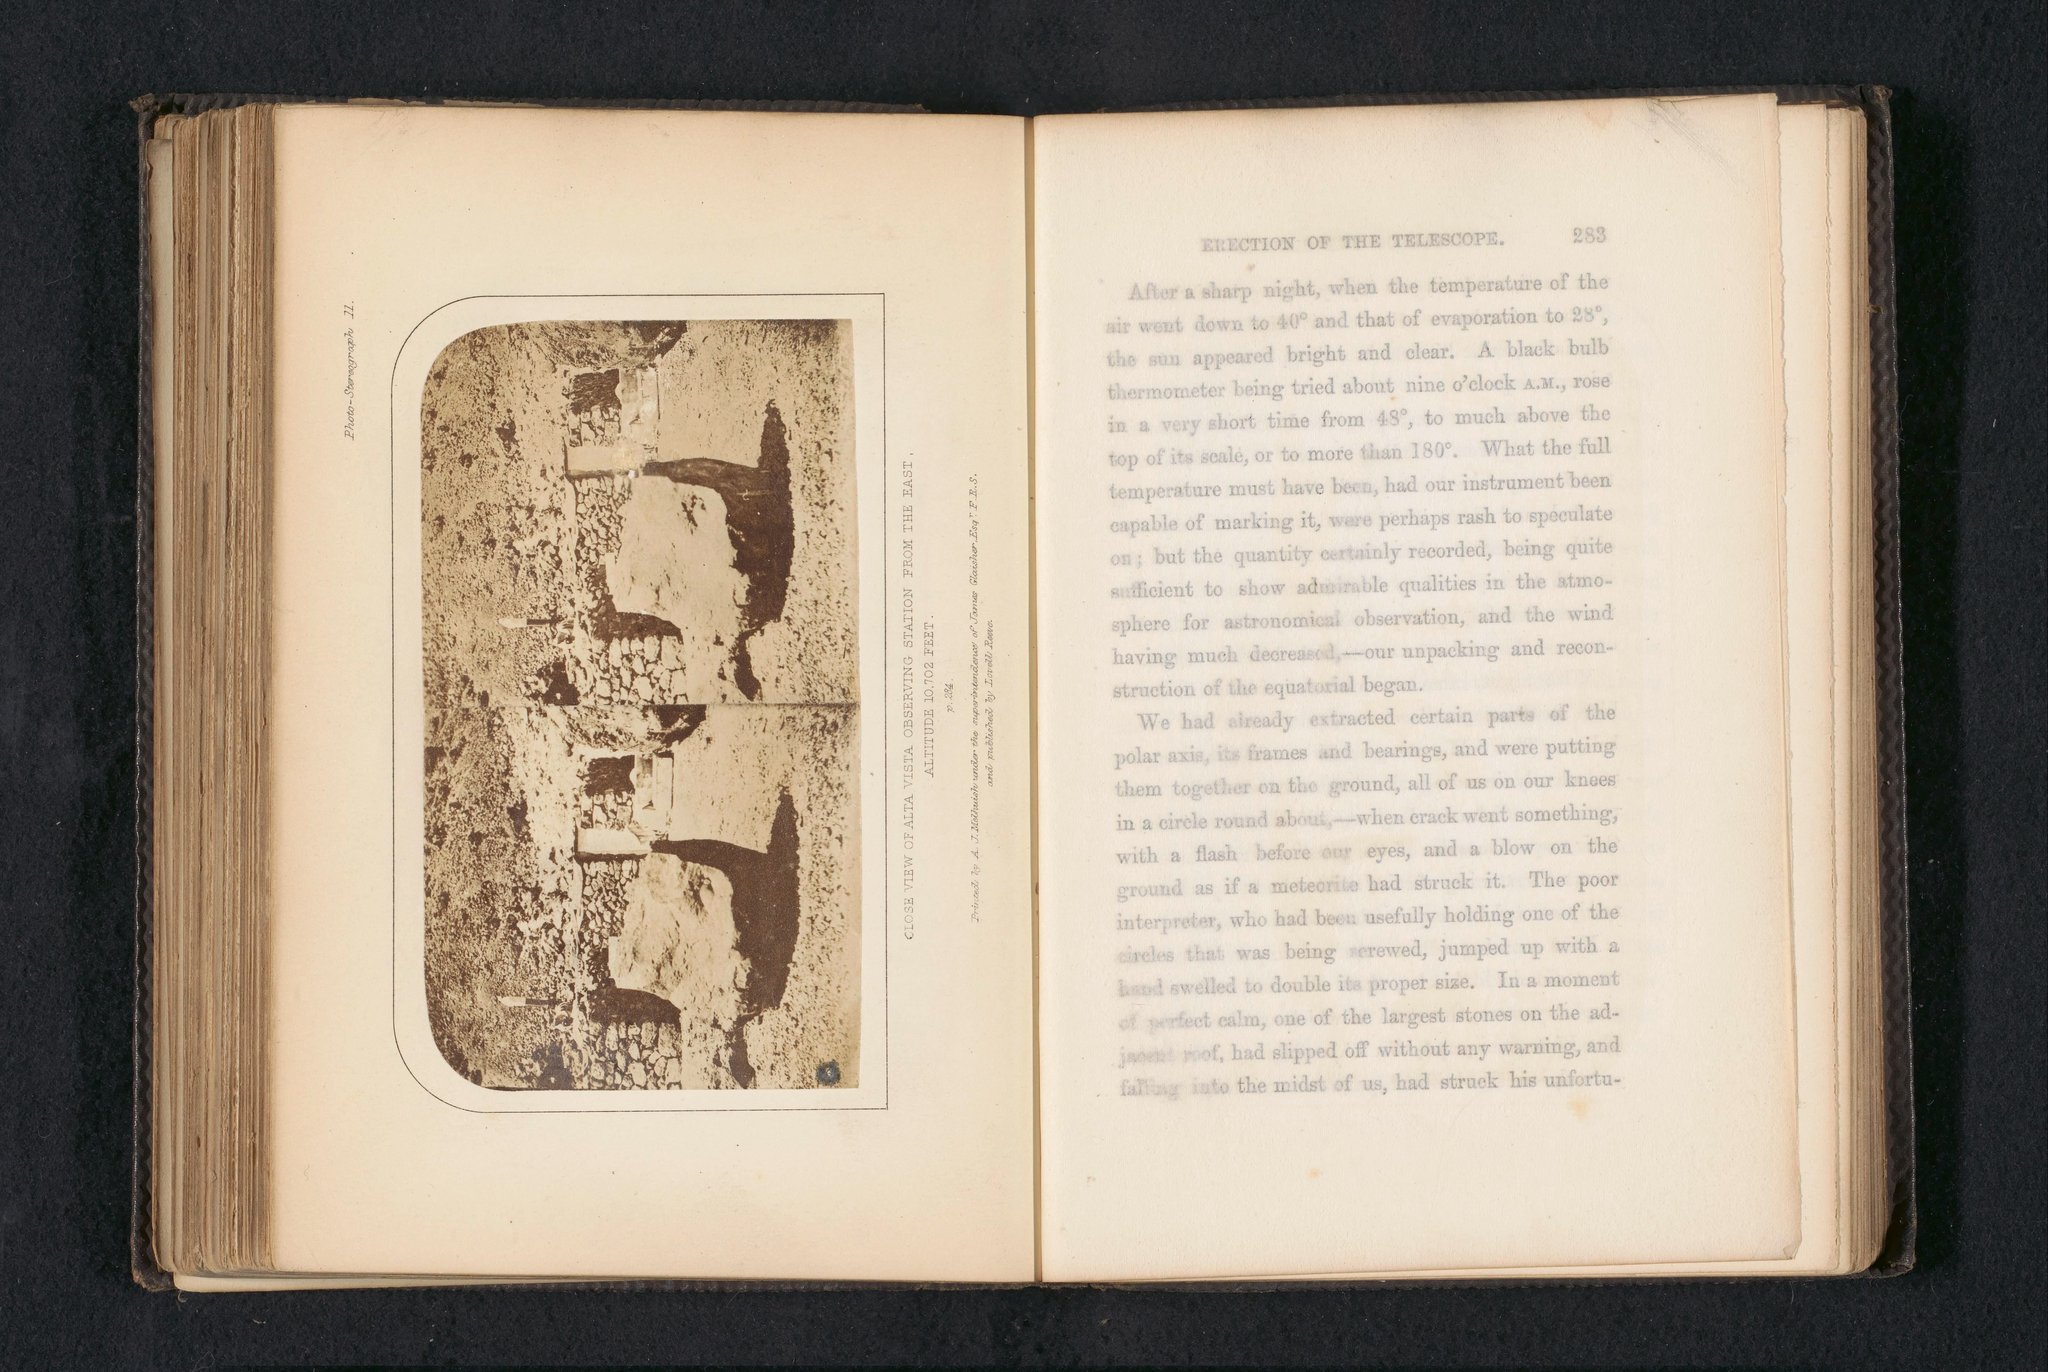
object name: stereograph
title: Close view of Alta Vista observing station from the East, altitude 10,702 feet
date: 1881-1886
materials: photographic support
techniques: albumen print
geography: tenerife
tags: façade (of house or building), volcano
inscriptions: number: ‘Photo-stereograph 11.’